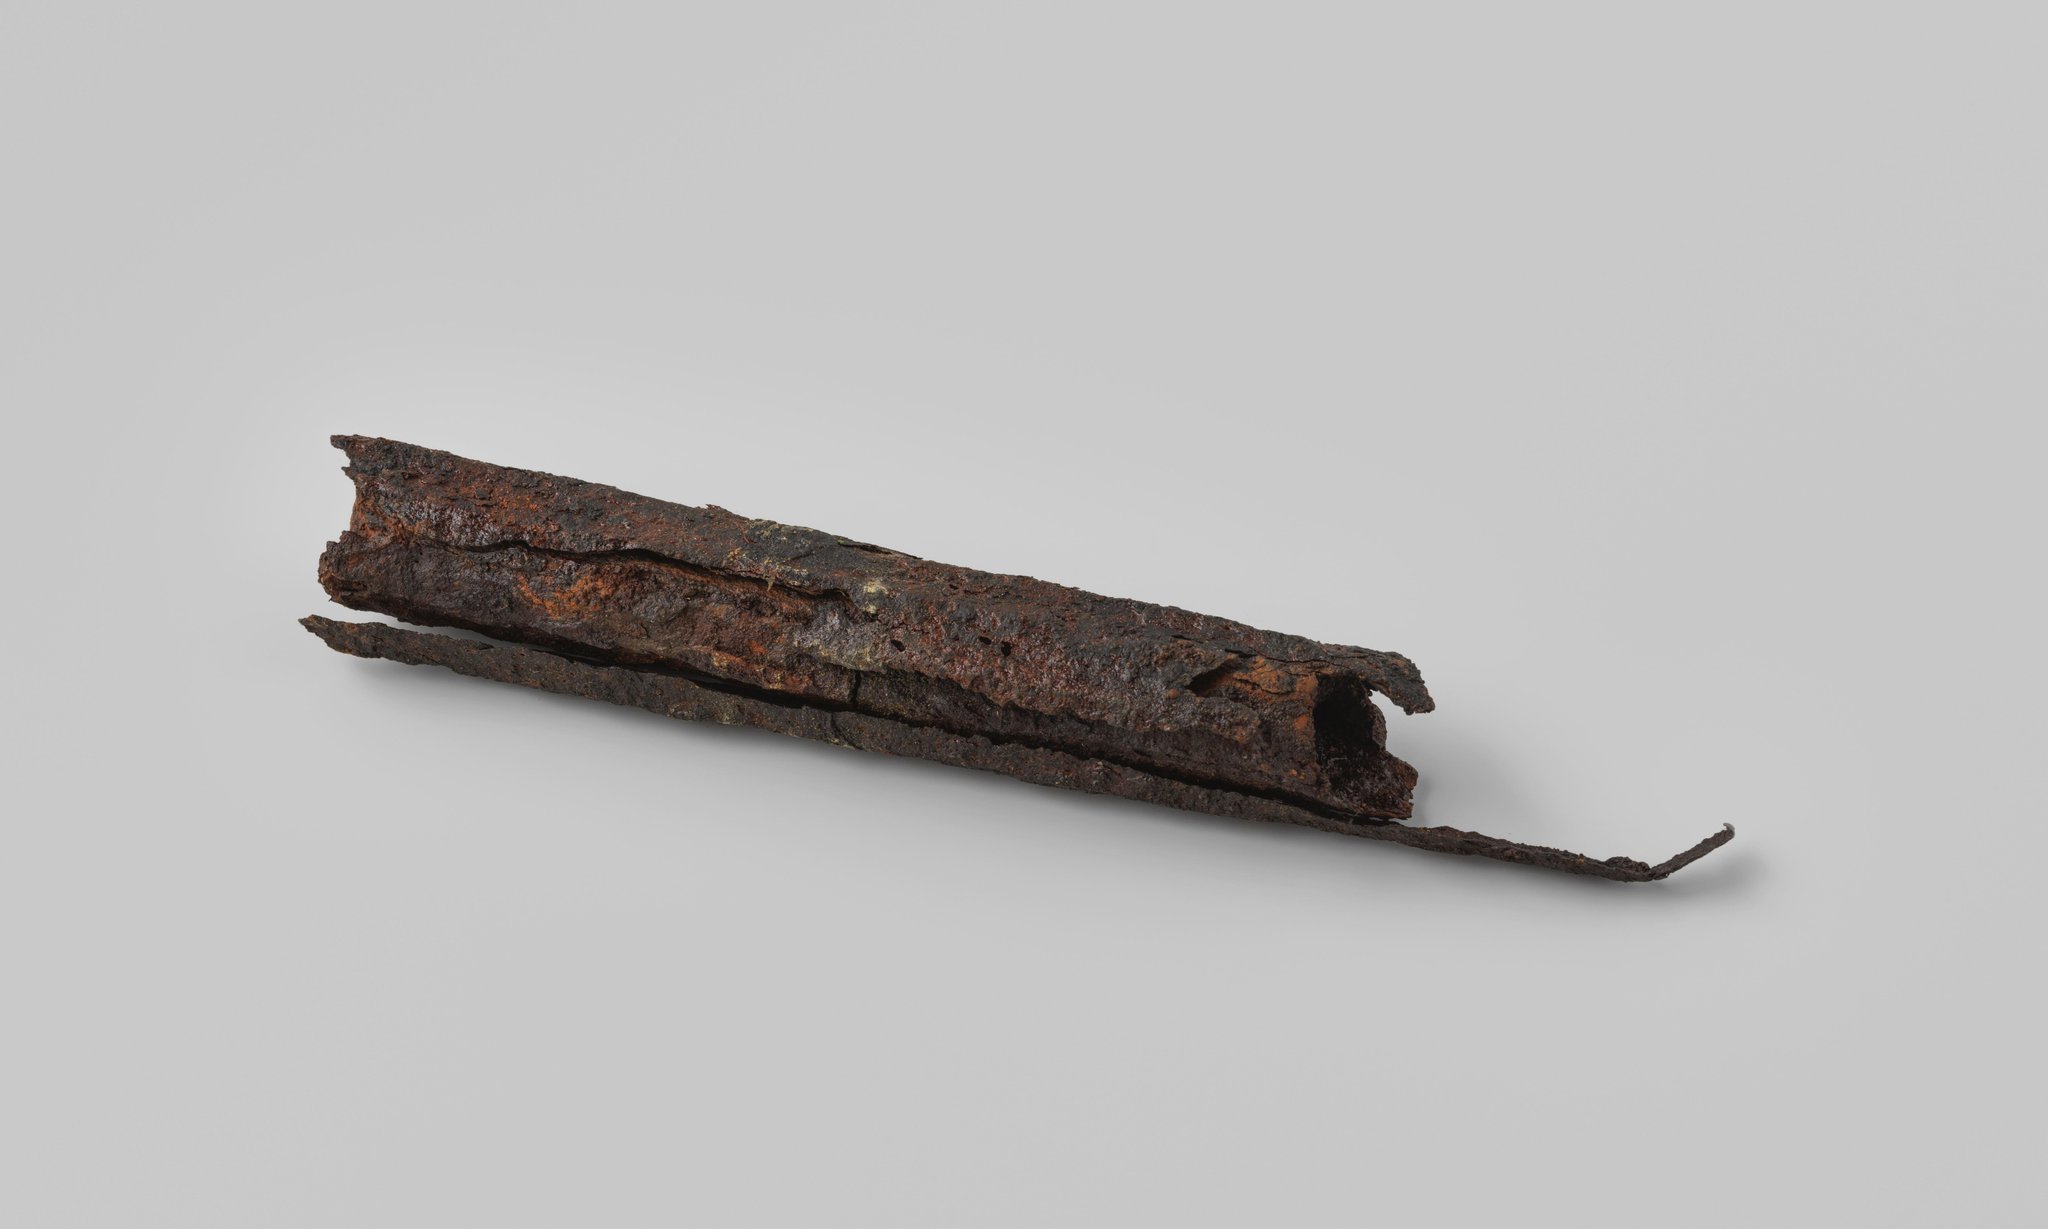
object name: barrel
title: Musketloop uit het wrak van de Oost-Indiëvaarder Hollandia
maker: Anonymous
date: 1700-1743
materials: iron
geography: netherlands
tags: verenigde oostindische compagnie, hollandia (schip), annet